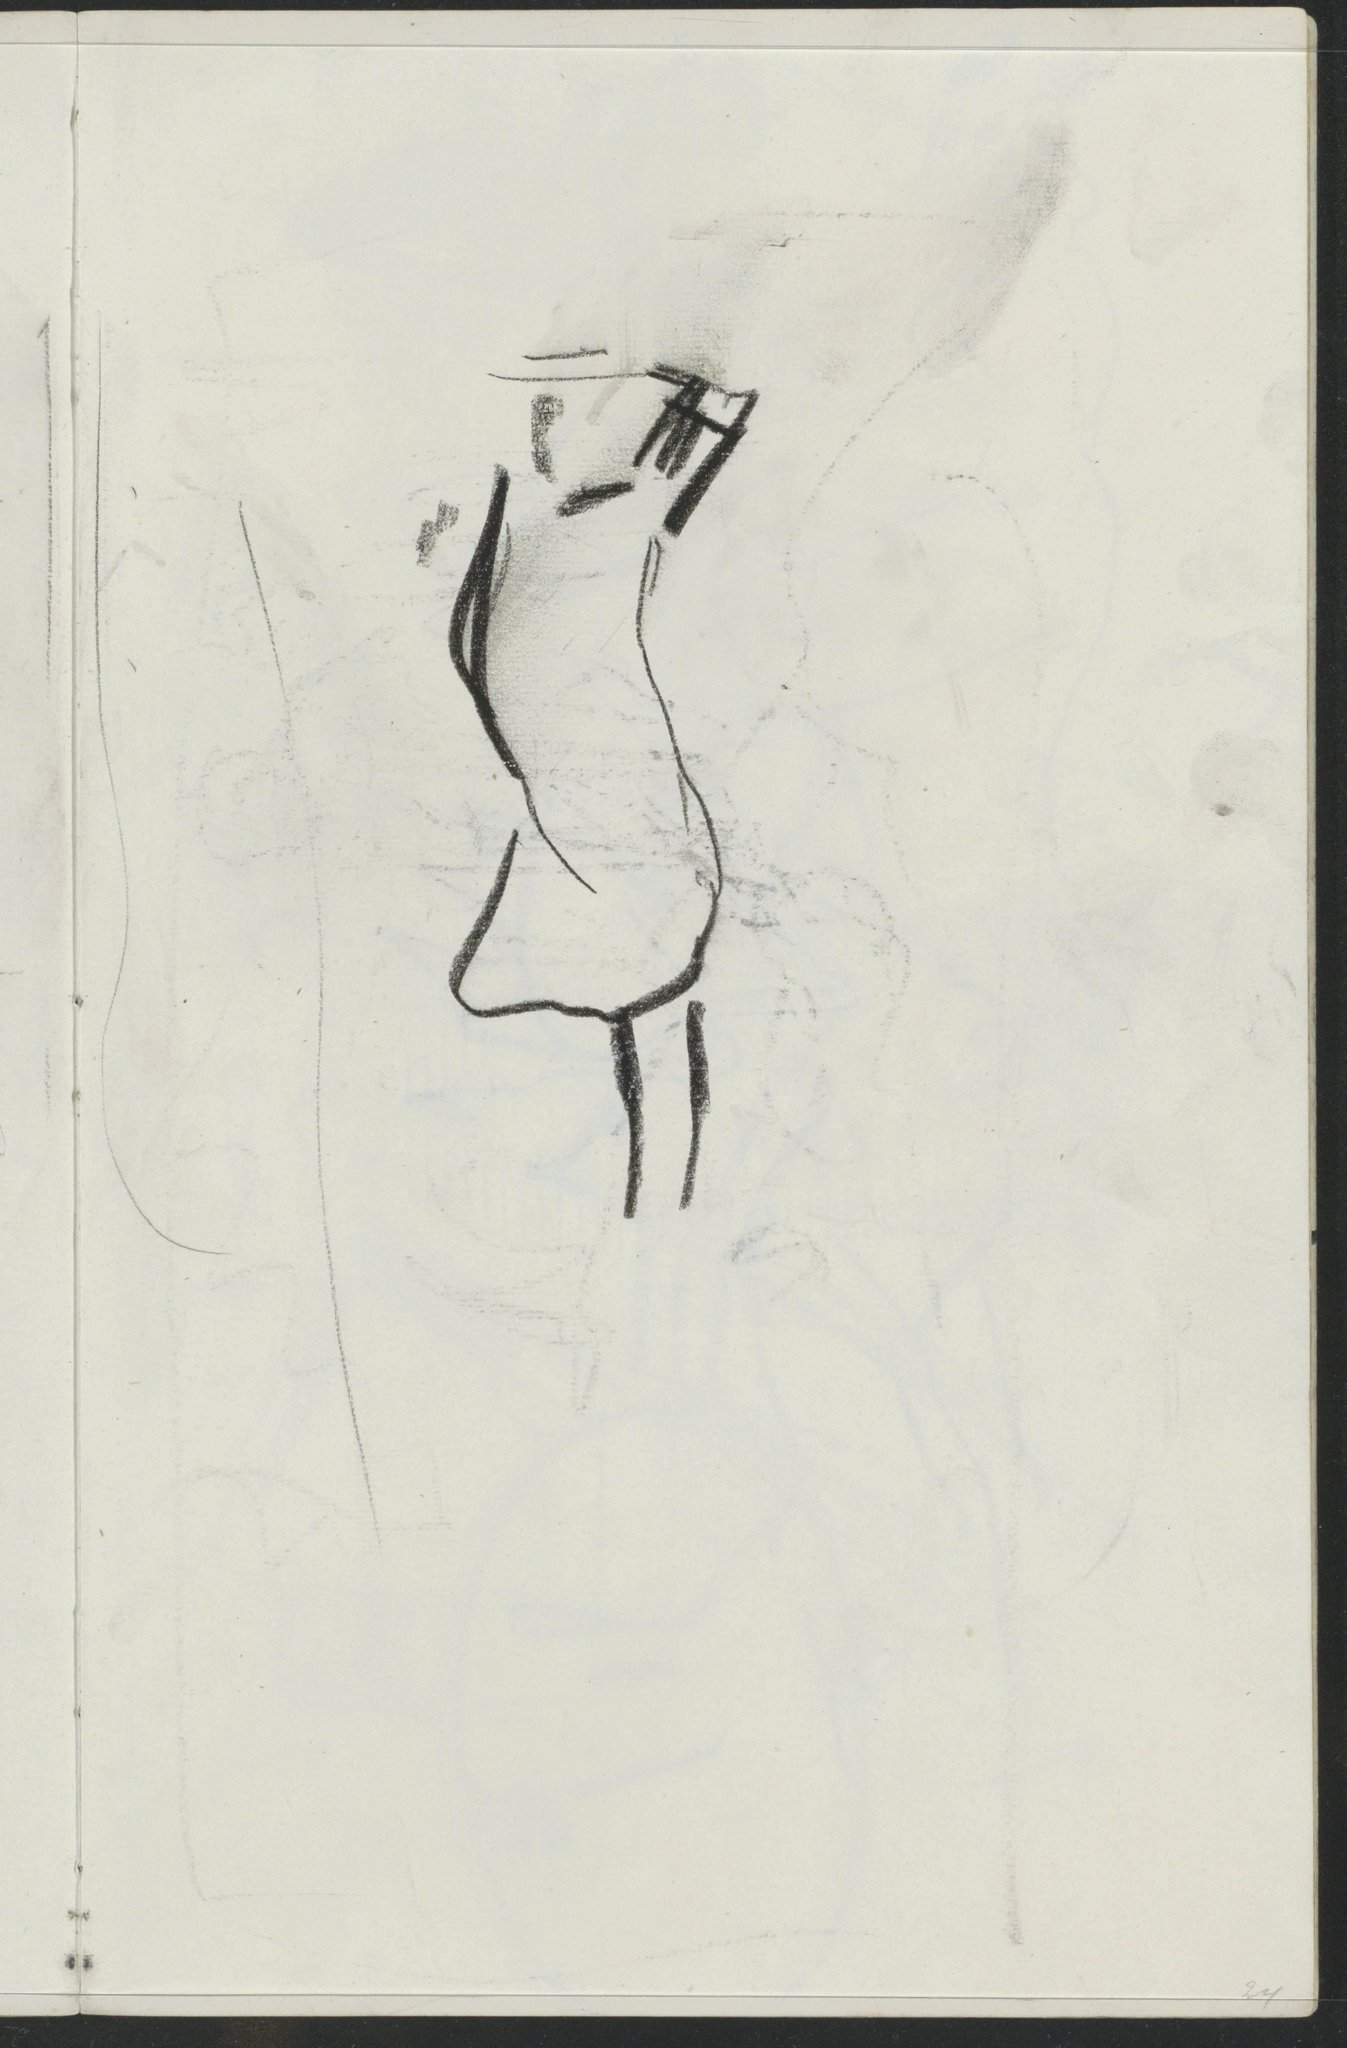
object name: sketchbook leaf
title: Staande jonge vrouw met opgeheven arm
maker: isaac israels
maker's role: draughtsman, painter, print maker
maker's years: 1865-1934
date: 1875-1934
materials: chalk, paper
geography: amsterdam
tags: adolescent, young woman, maiden (+ standing)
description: Blad 24 recto uit schetsboek XI met 30 bladen.